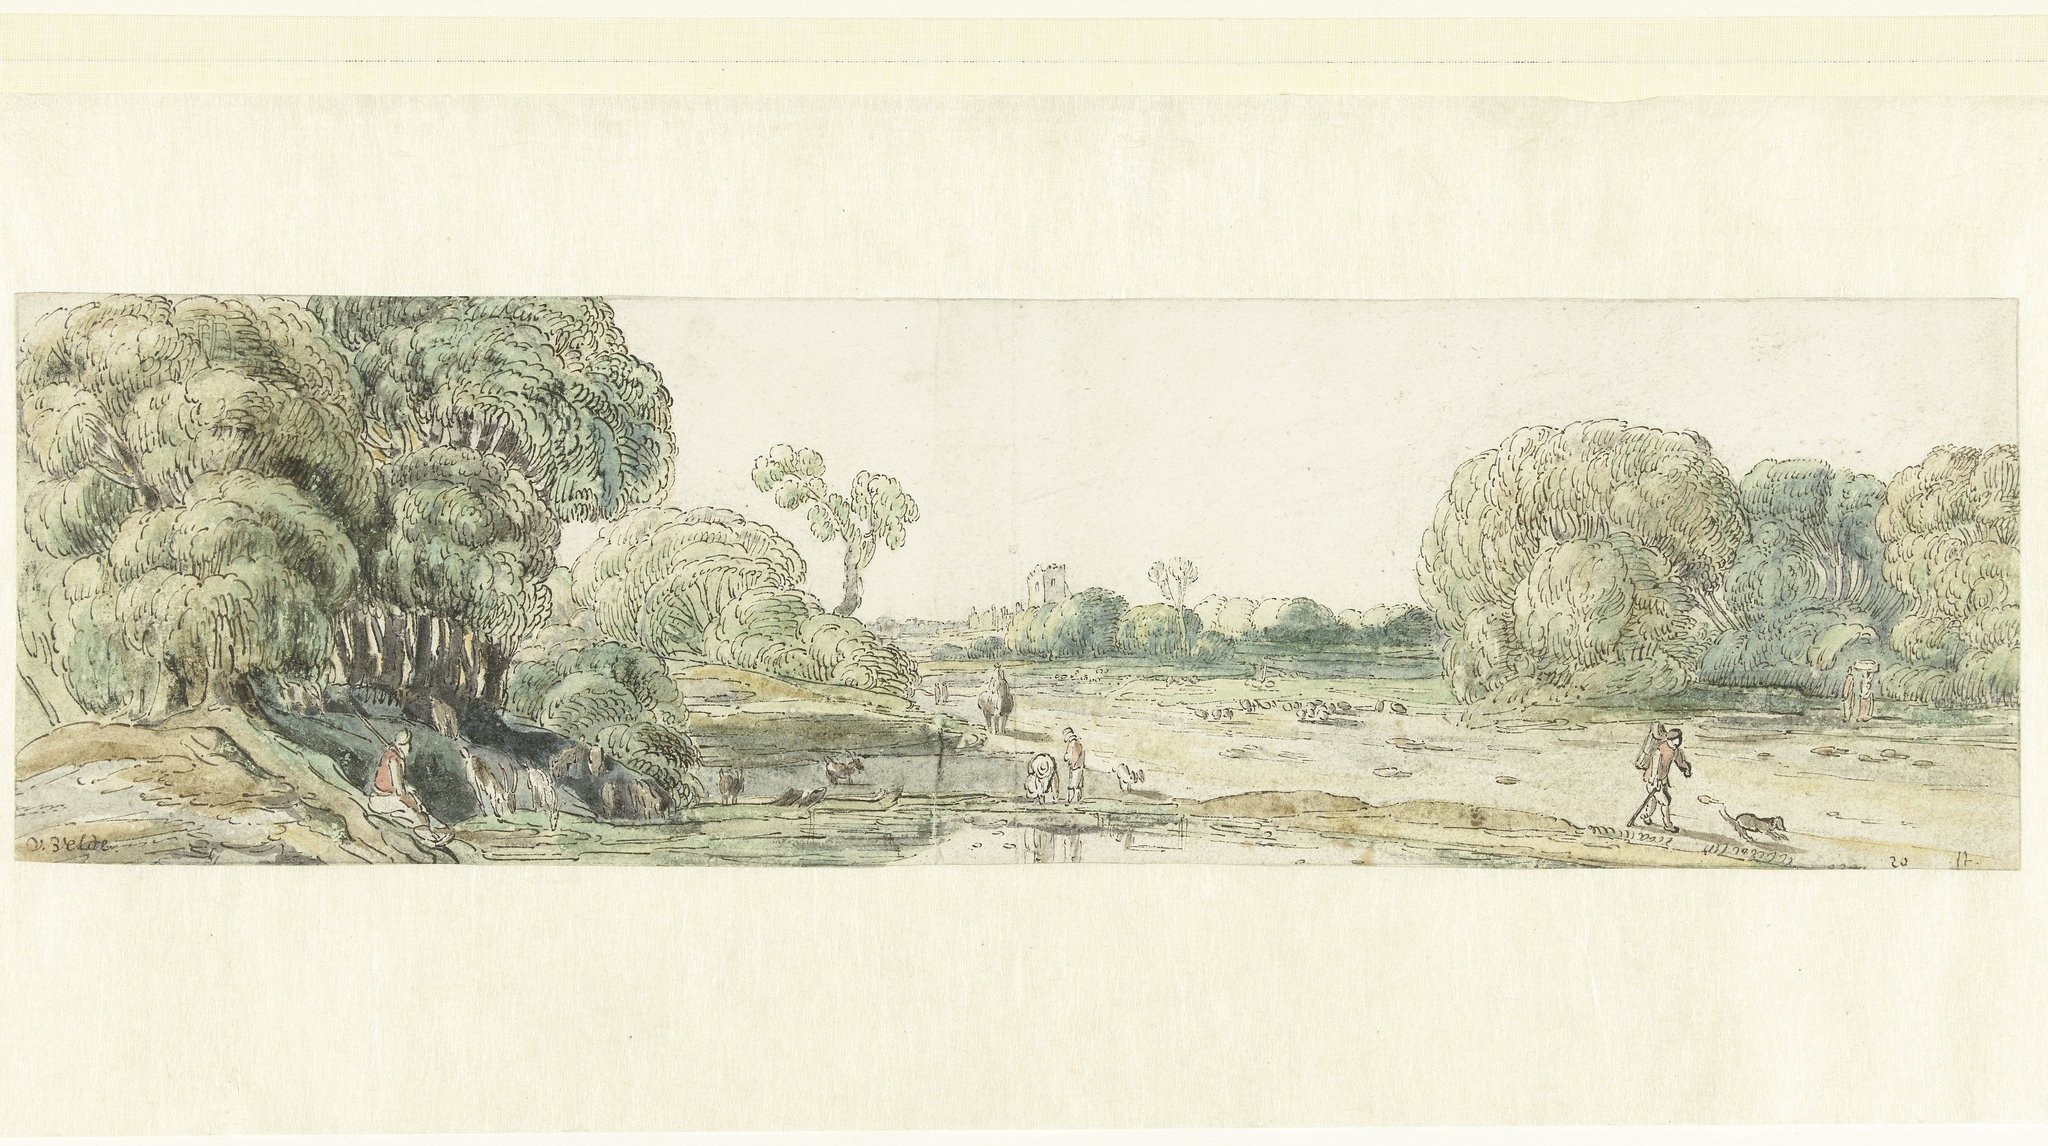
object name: drawing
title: Weg tussen boomgroepen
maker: jan van de velde (ii)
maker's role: draughtsman, painter, print maker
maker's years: 1593-1641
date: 1603-1641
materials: ink, paper, watercolor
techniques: brush, pen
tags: landscapes in the temperate zone, herd, flock